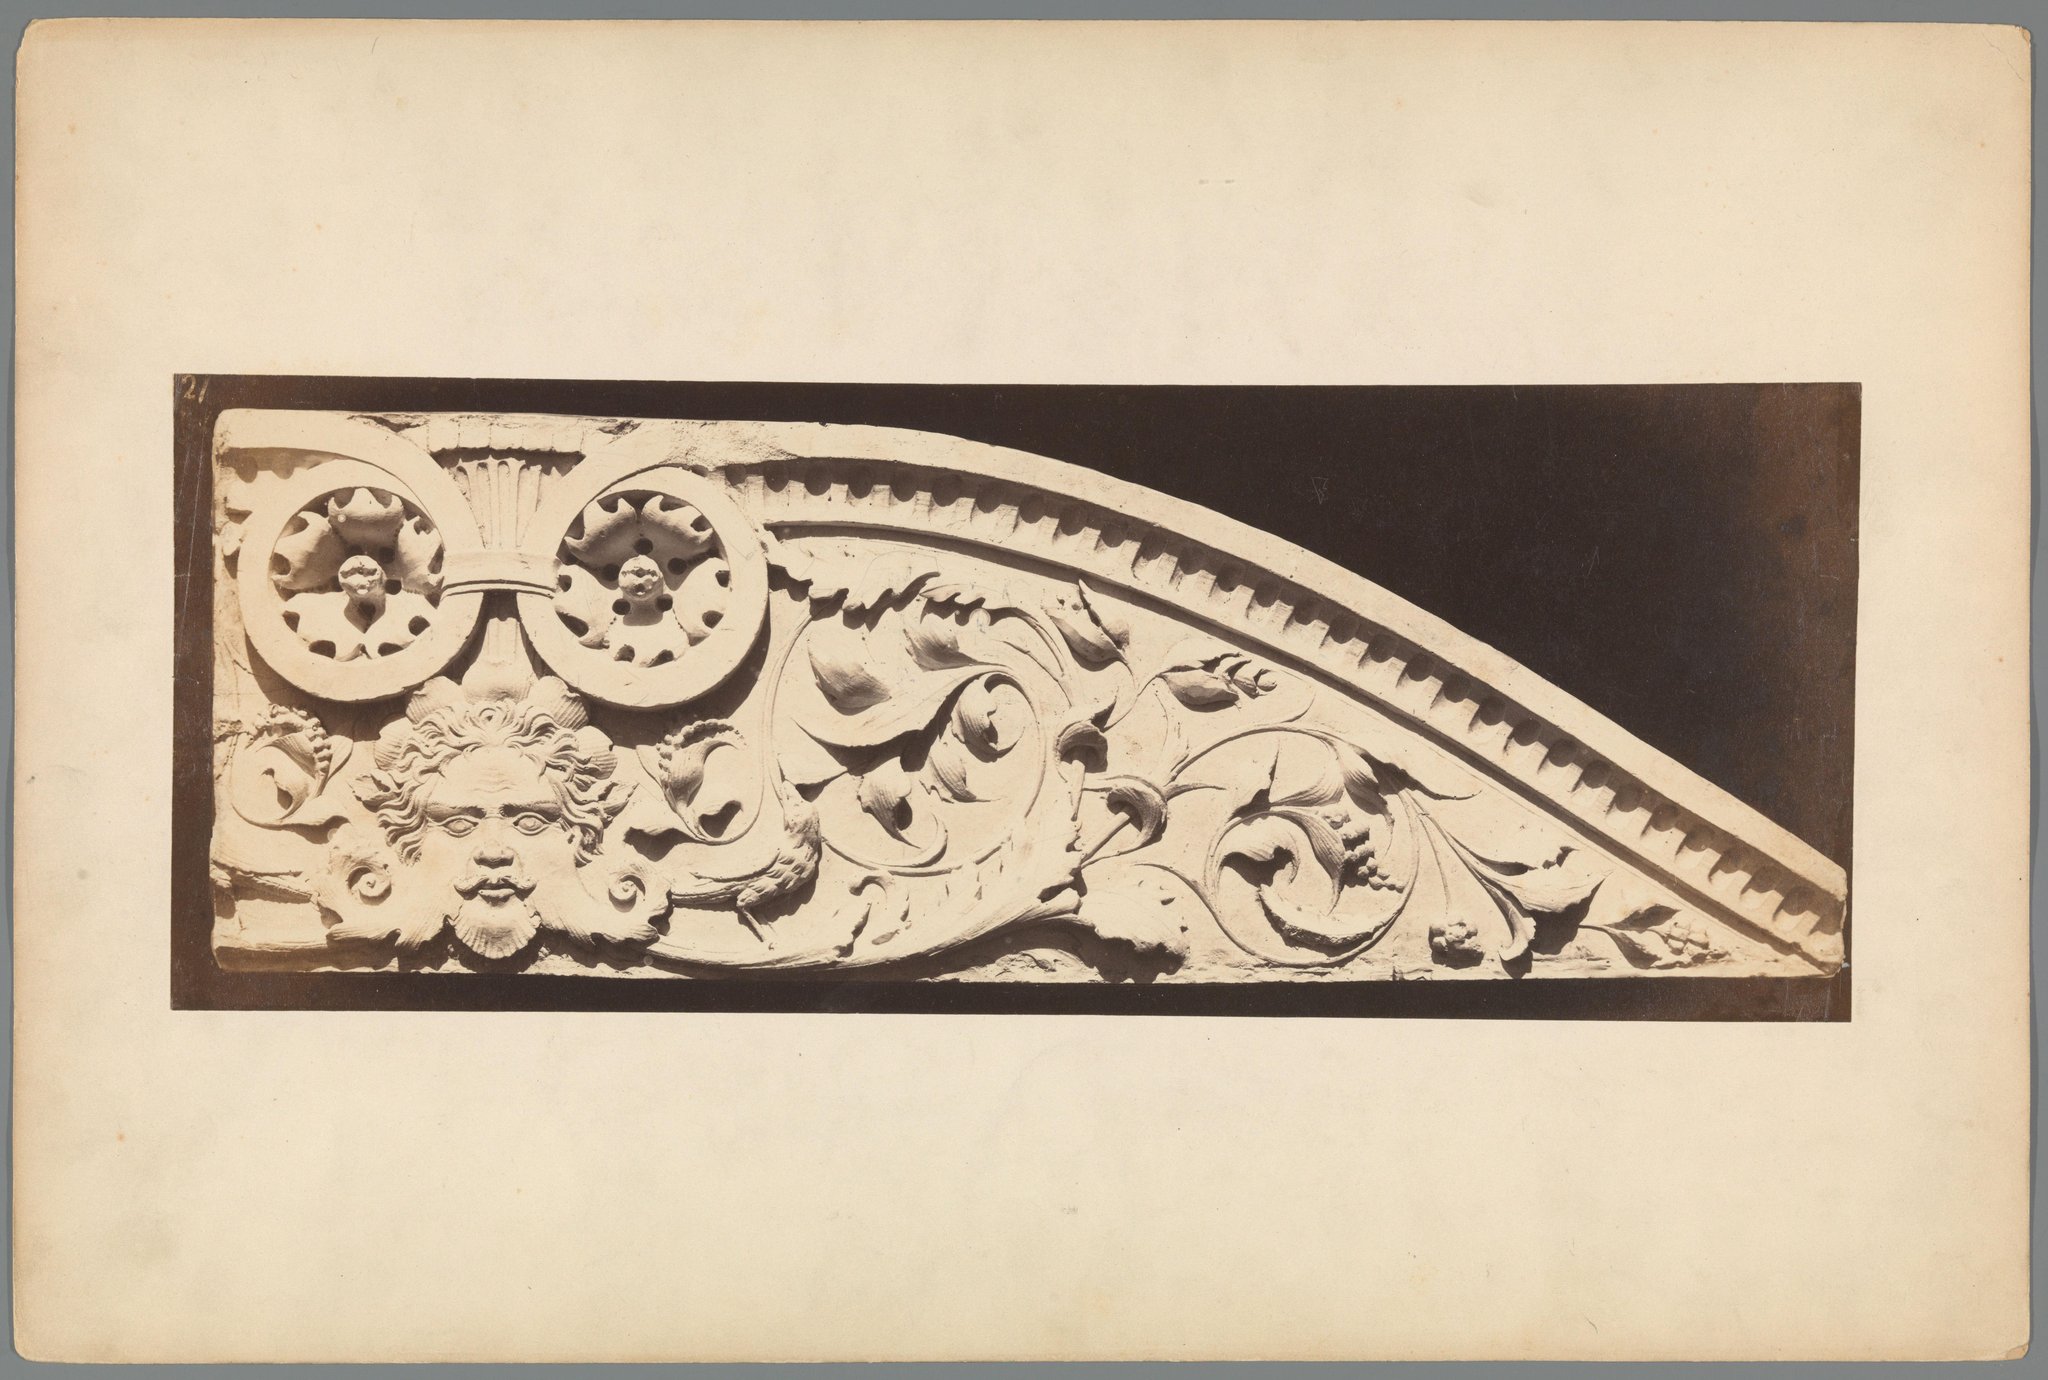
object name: photograph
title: Reliëf met een maskerkop en een plantmotief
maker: Anonymous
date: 1875-1900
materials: cardboard, photographic support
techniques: albumen print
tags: ornamental birds, ornament ~ arabesque, mask, mascaron ~ ornament, sculpture (+ relief ~ sculpture)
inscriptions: collector's mark: Lugt 3937, number: ‘21’